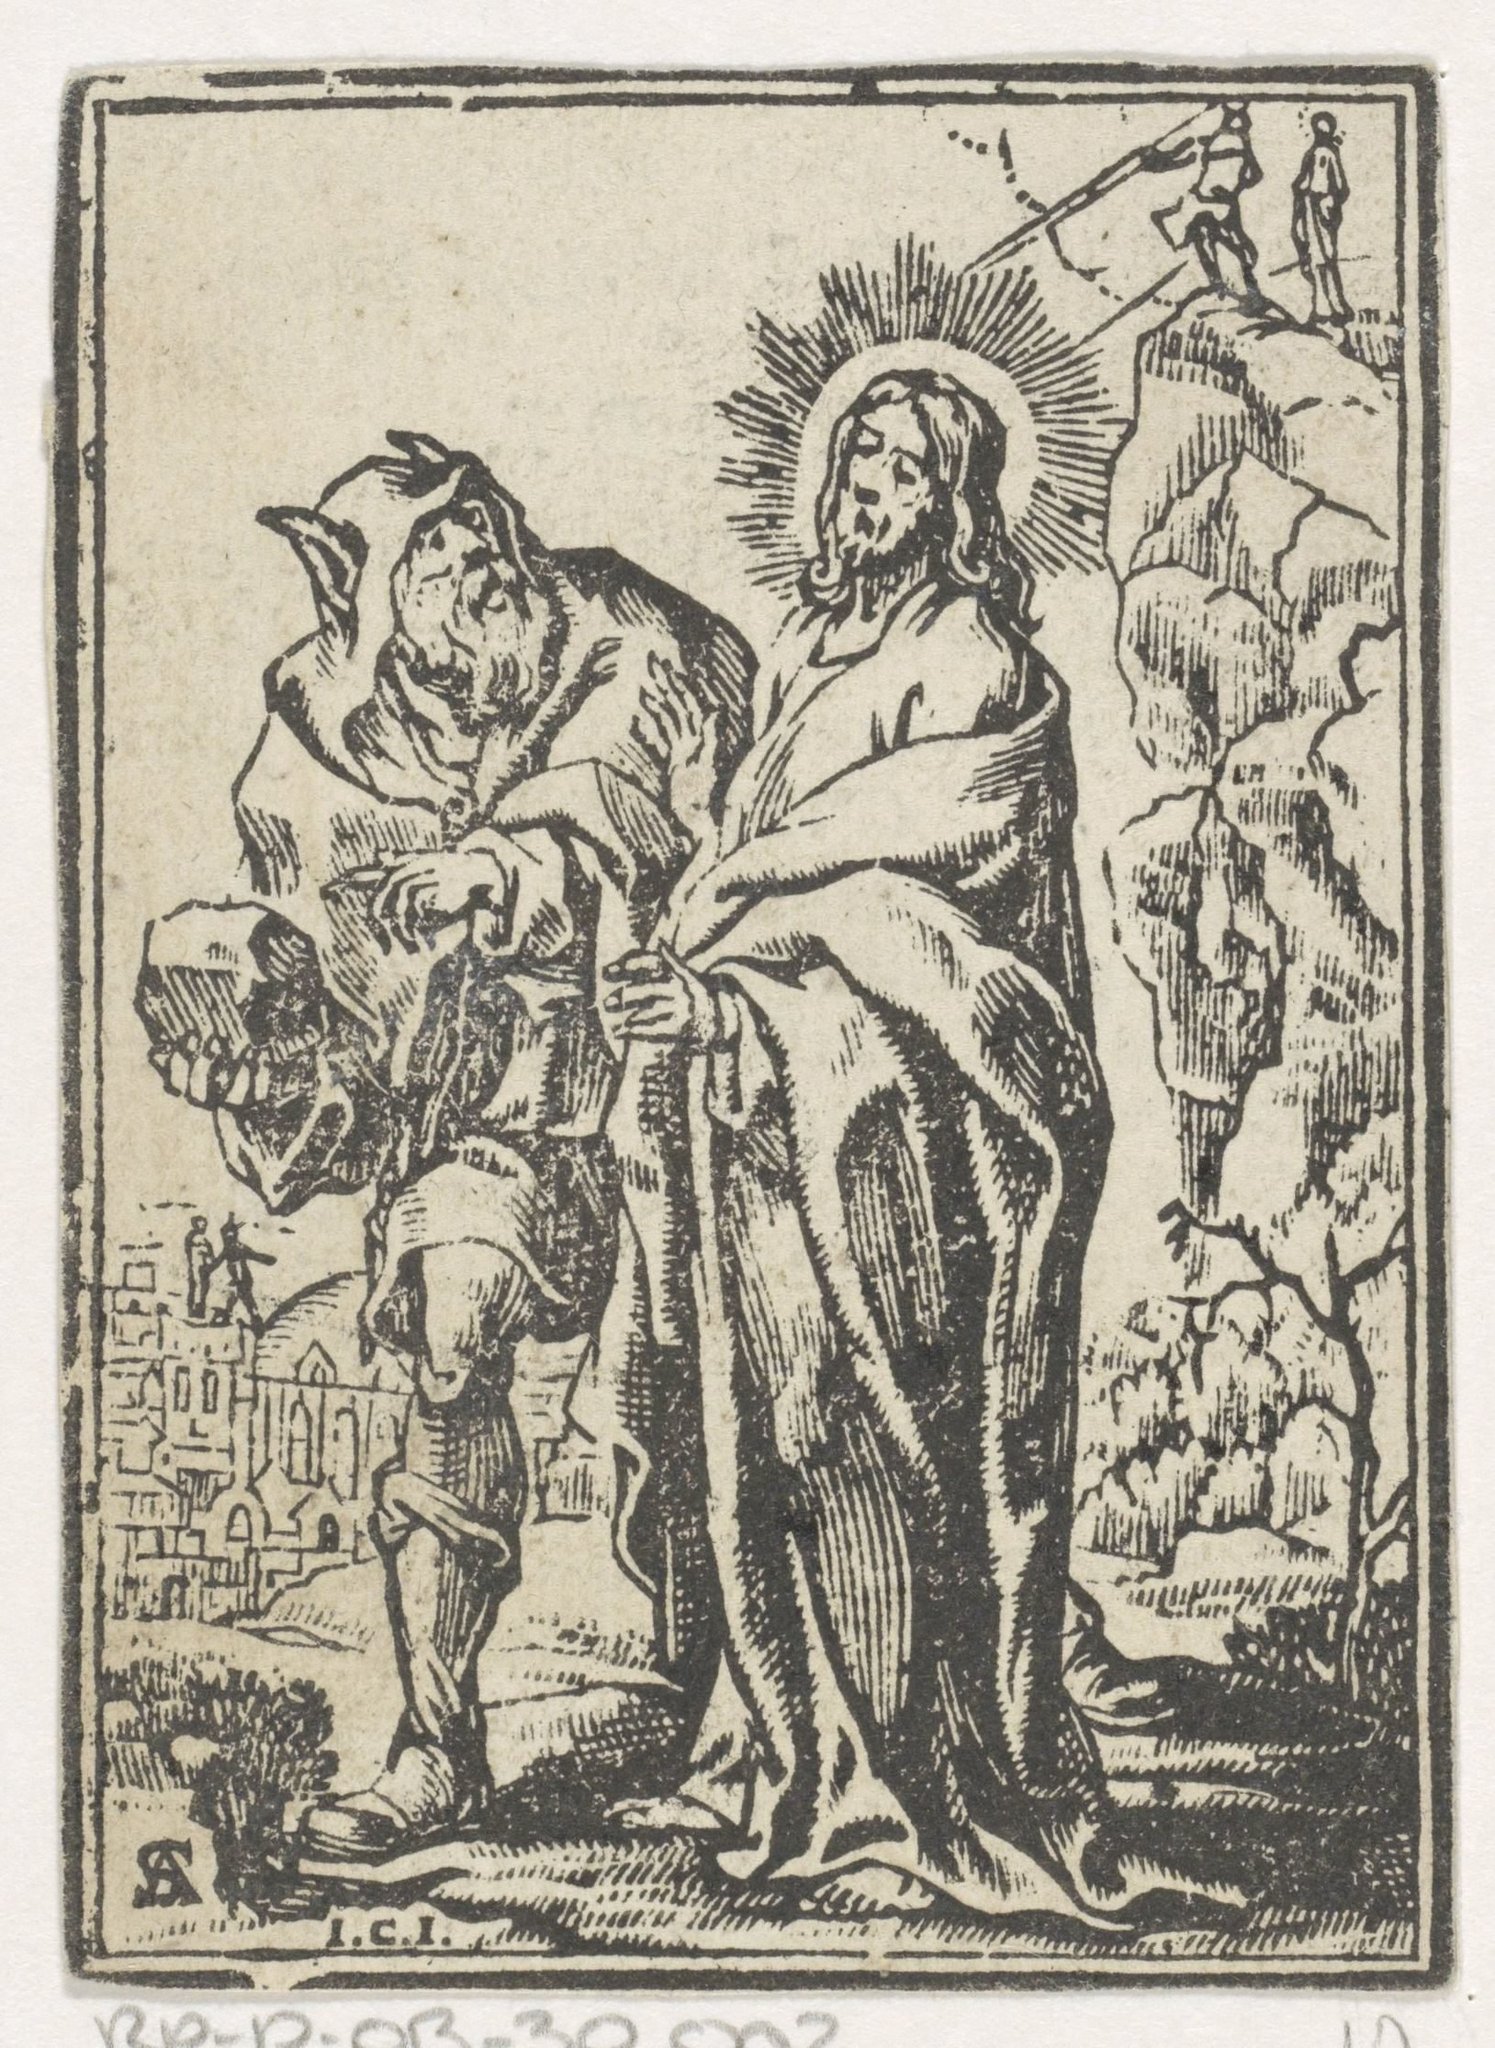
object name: print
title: Verzoeking van Christus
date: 1649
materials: paper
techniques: letterpress printing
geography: antwerp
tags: 'command these stones to become loaves of bread' ~ temptation of christ in the wilderness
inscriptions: collector's mark: Lugt 240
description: De duivel in de gedaante van een oude man in monnikspij biedt Christus een steen aan en vraagt hem die in een brood te veranderen.